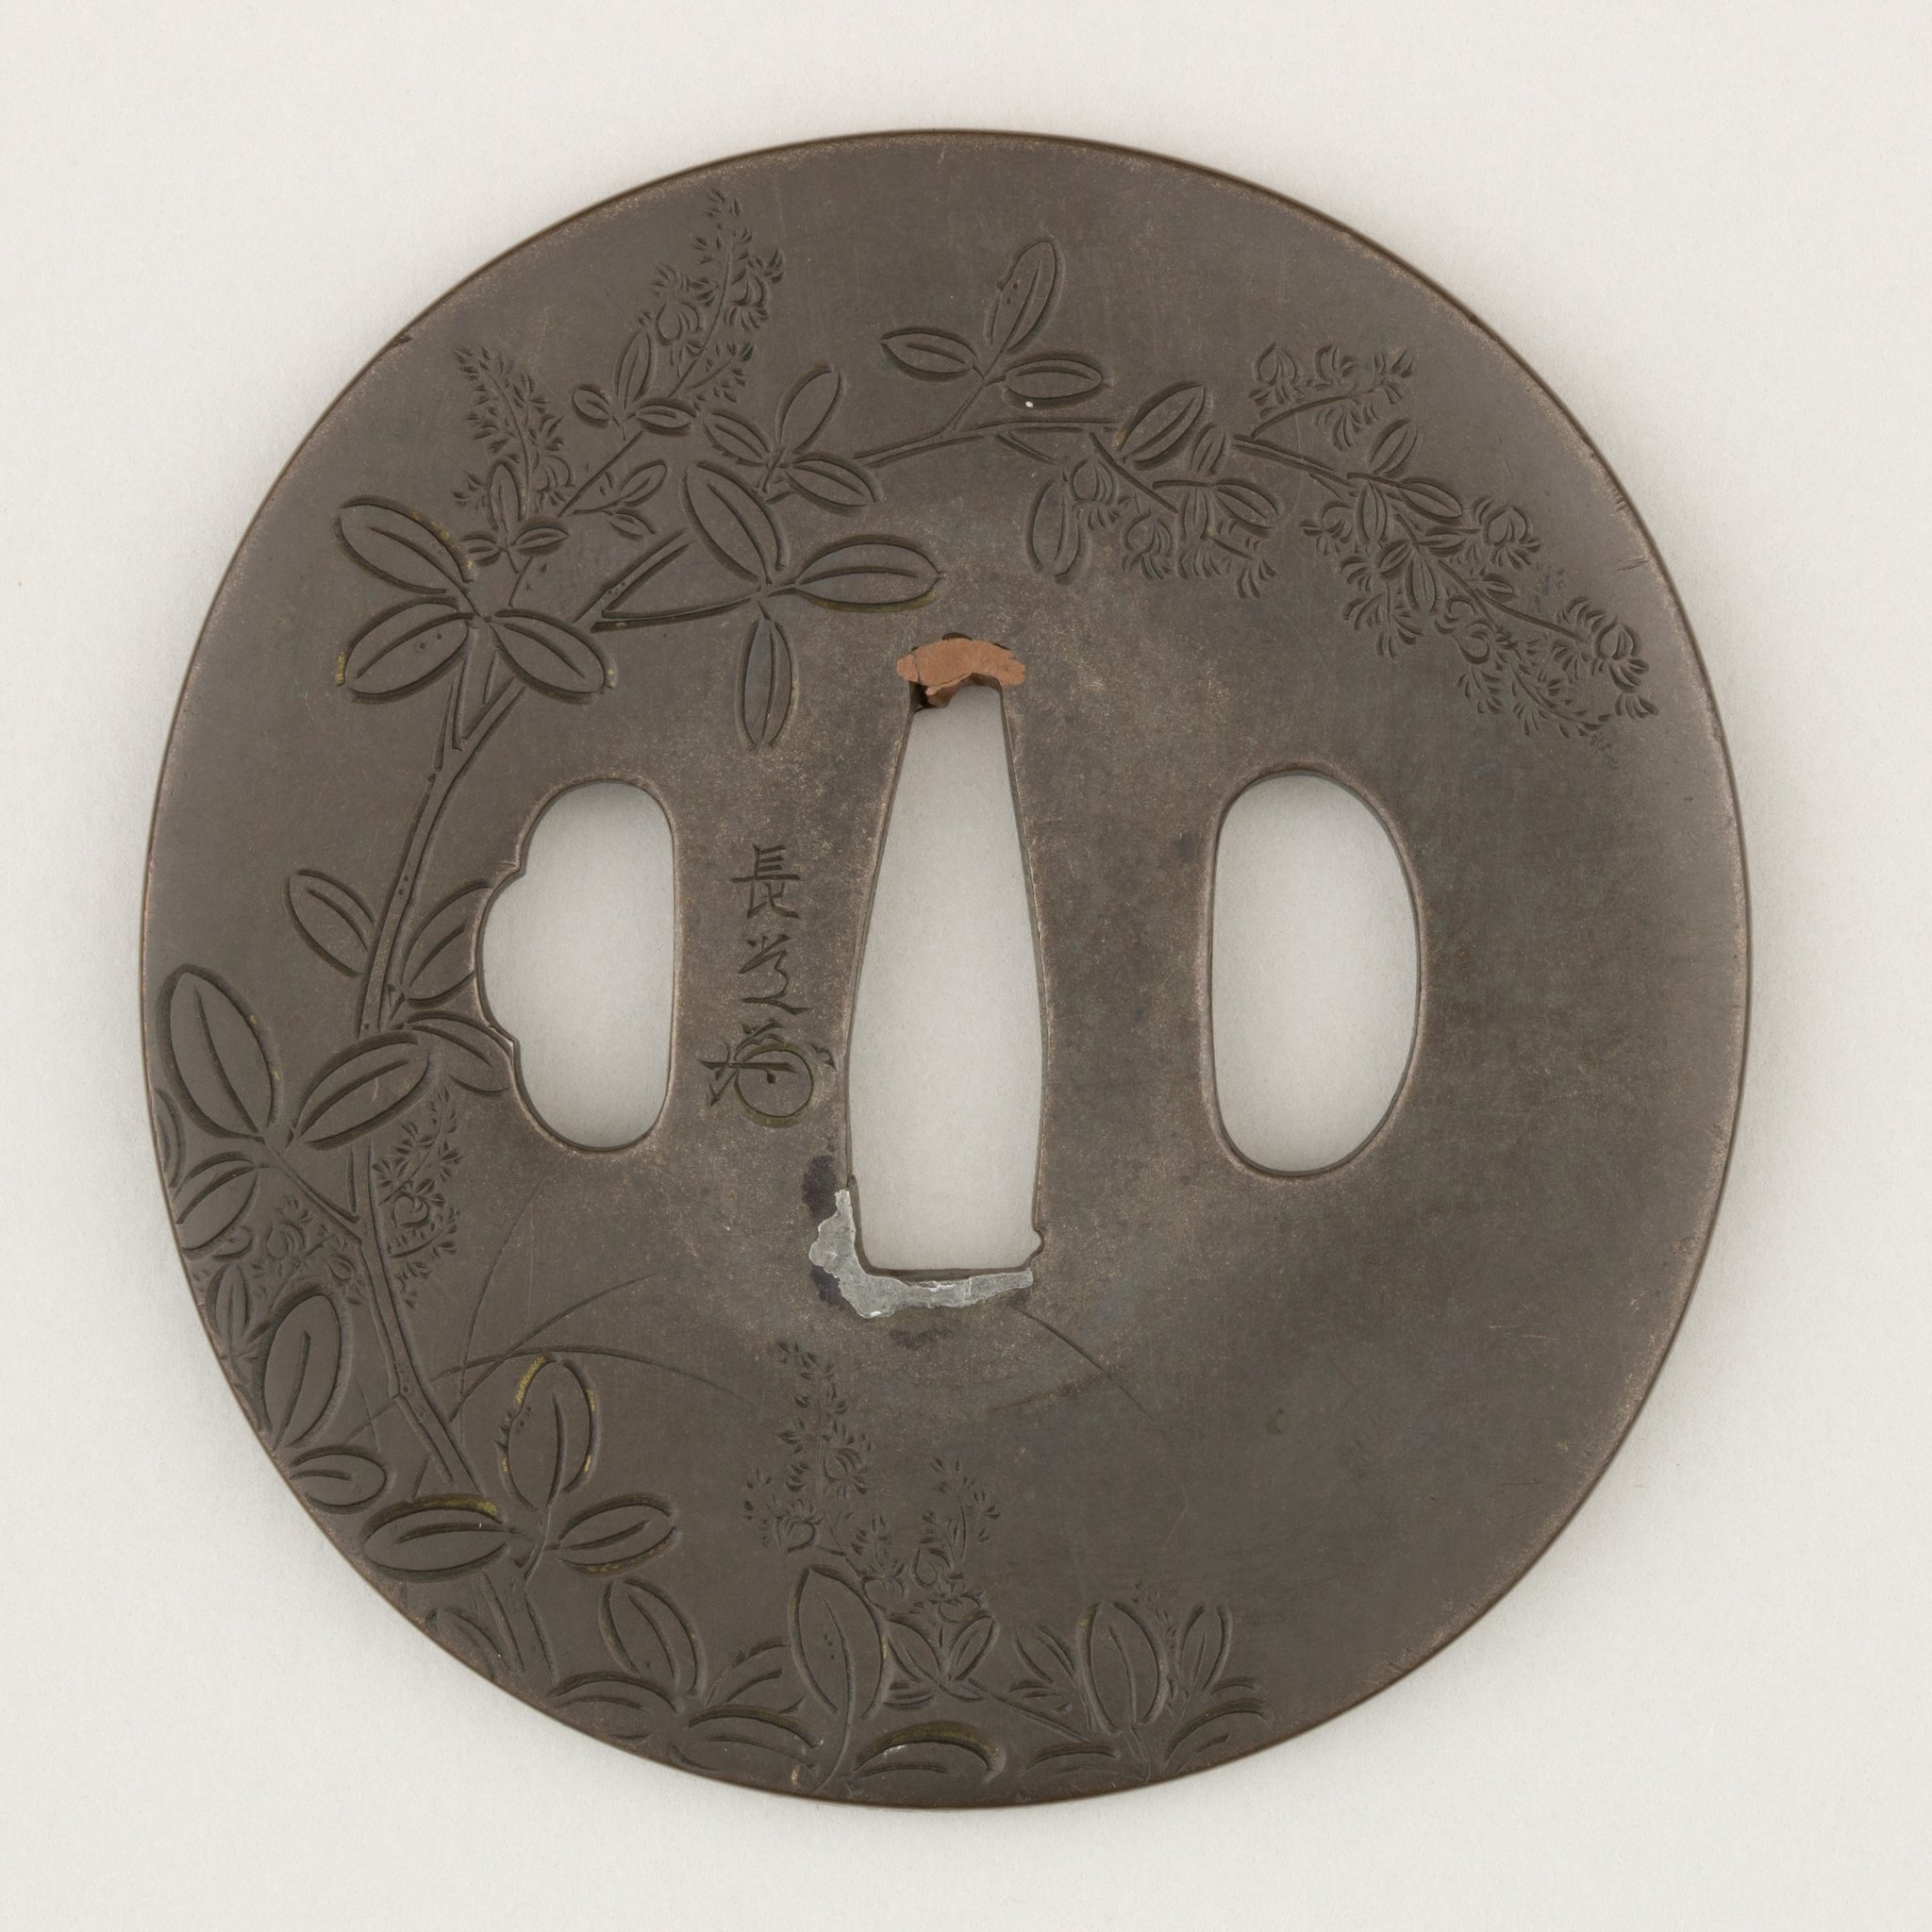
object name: sword guard tsuba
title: Sword Guard (Tsuba)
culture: japanese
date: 1801-1833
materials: copper, gold alloy, silver alloy, gold, silver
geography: japan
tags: plants